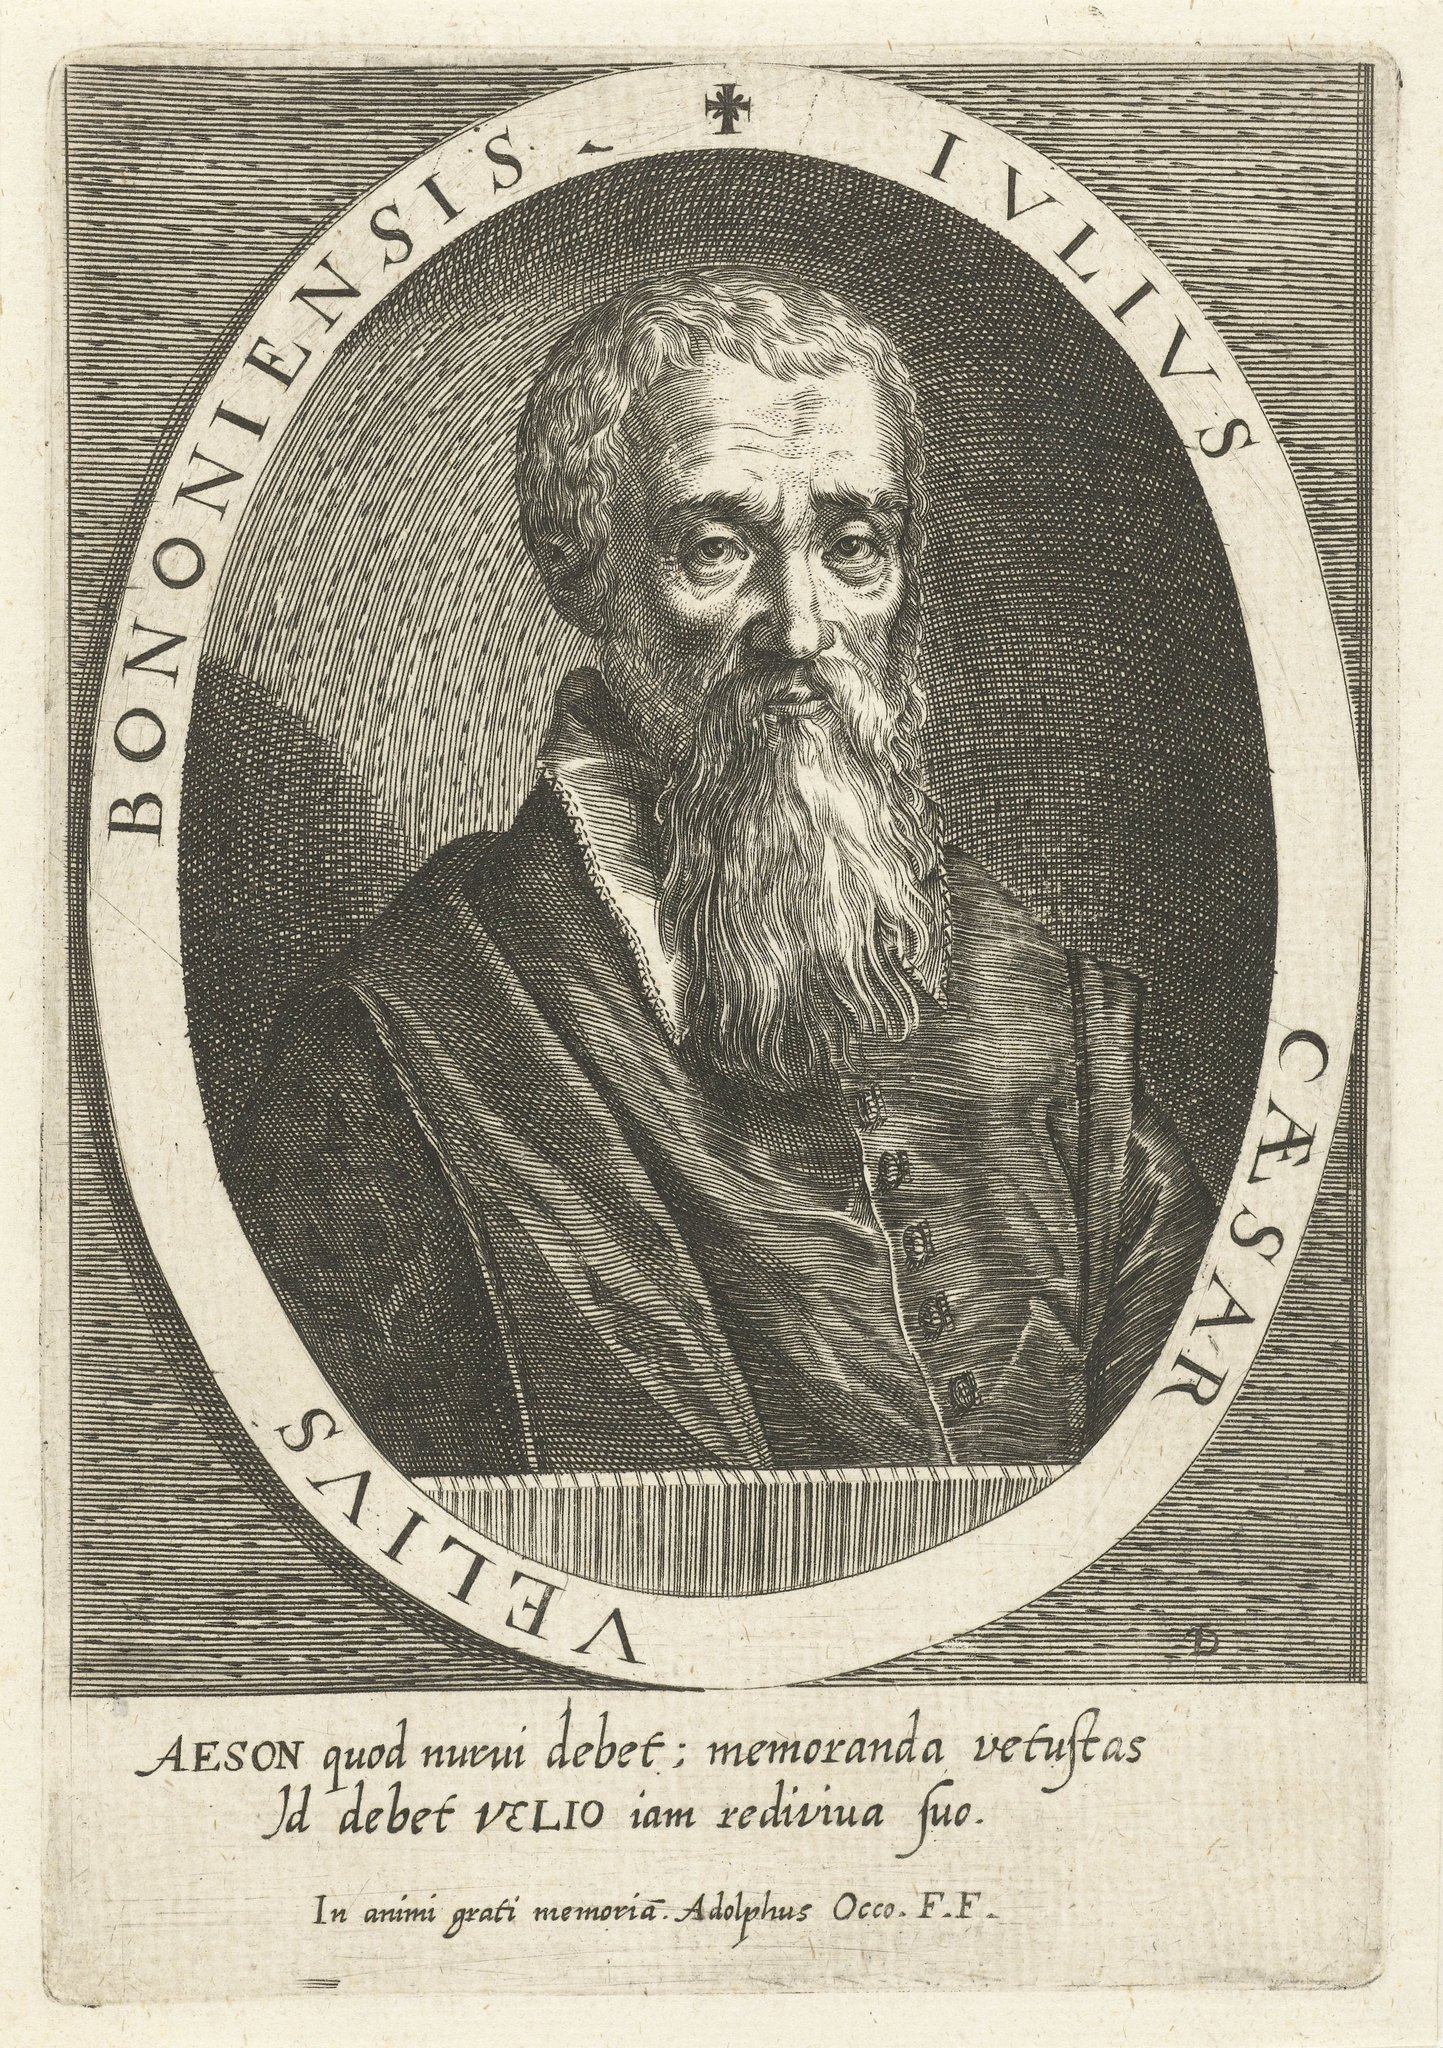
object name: print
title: Portret van Julius Caesar Velius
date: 1579-1615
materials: paper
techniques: engraving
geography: augsburg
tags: julius caesar velius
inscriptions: collector's mark: Lugt 2228